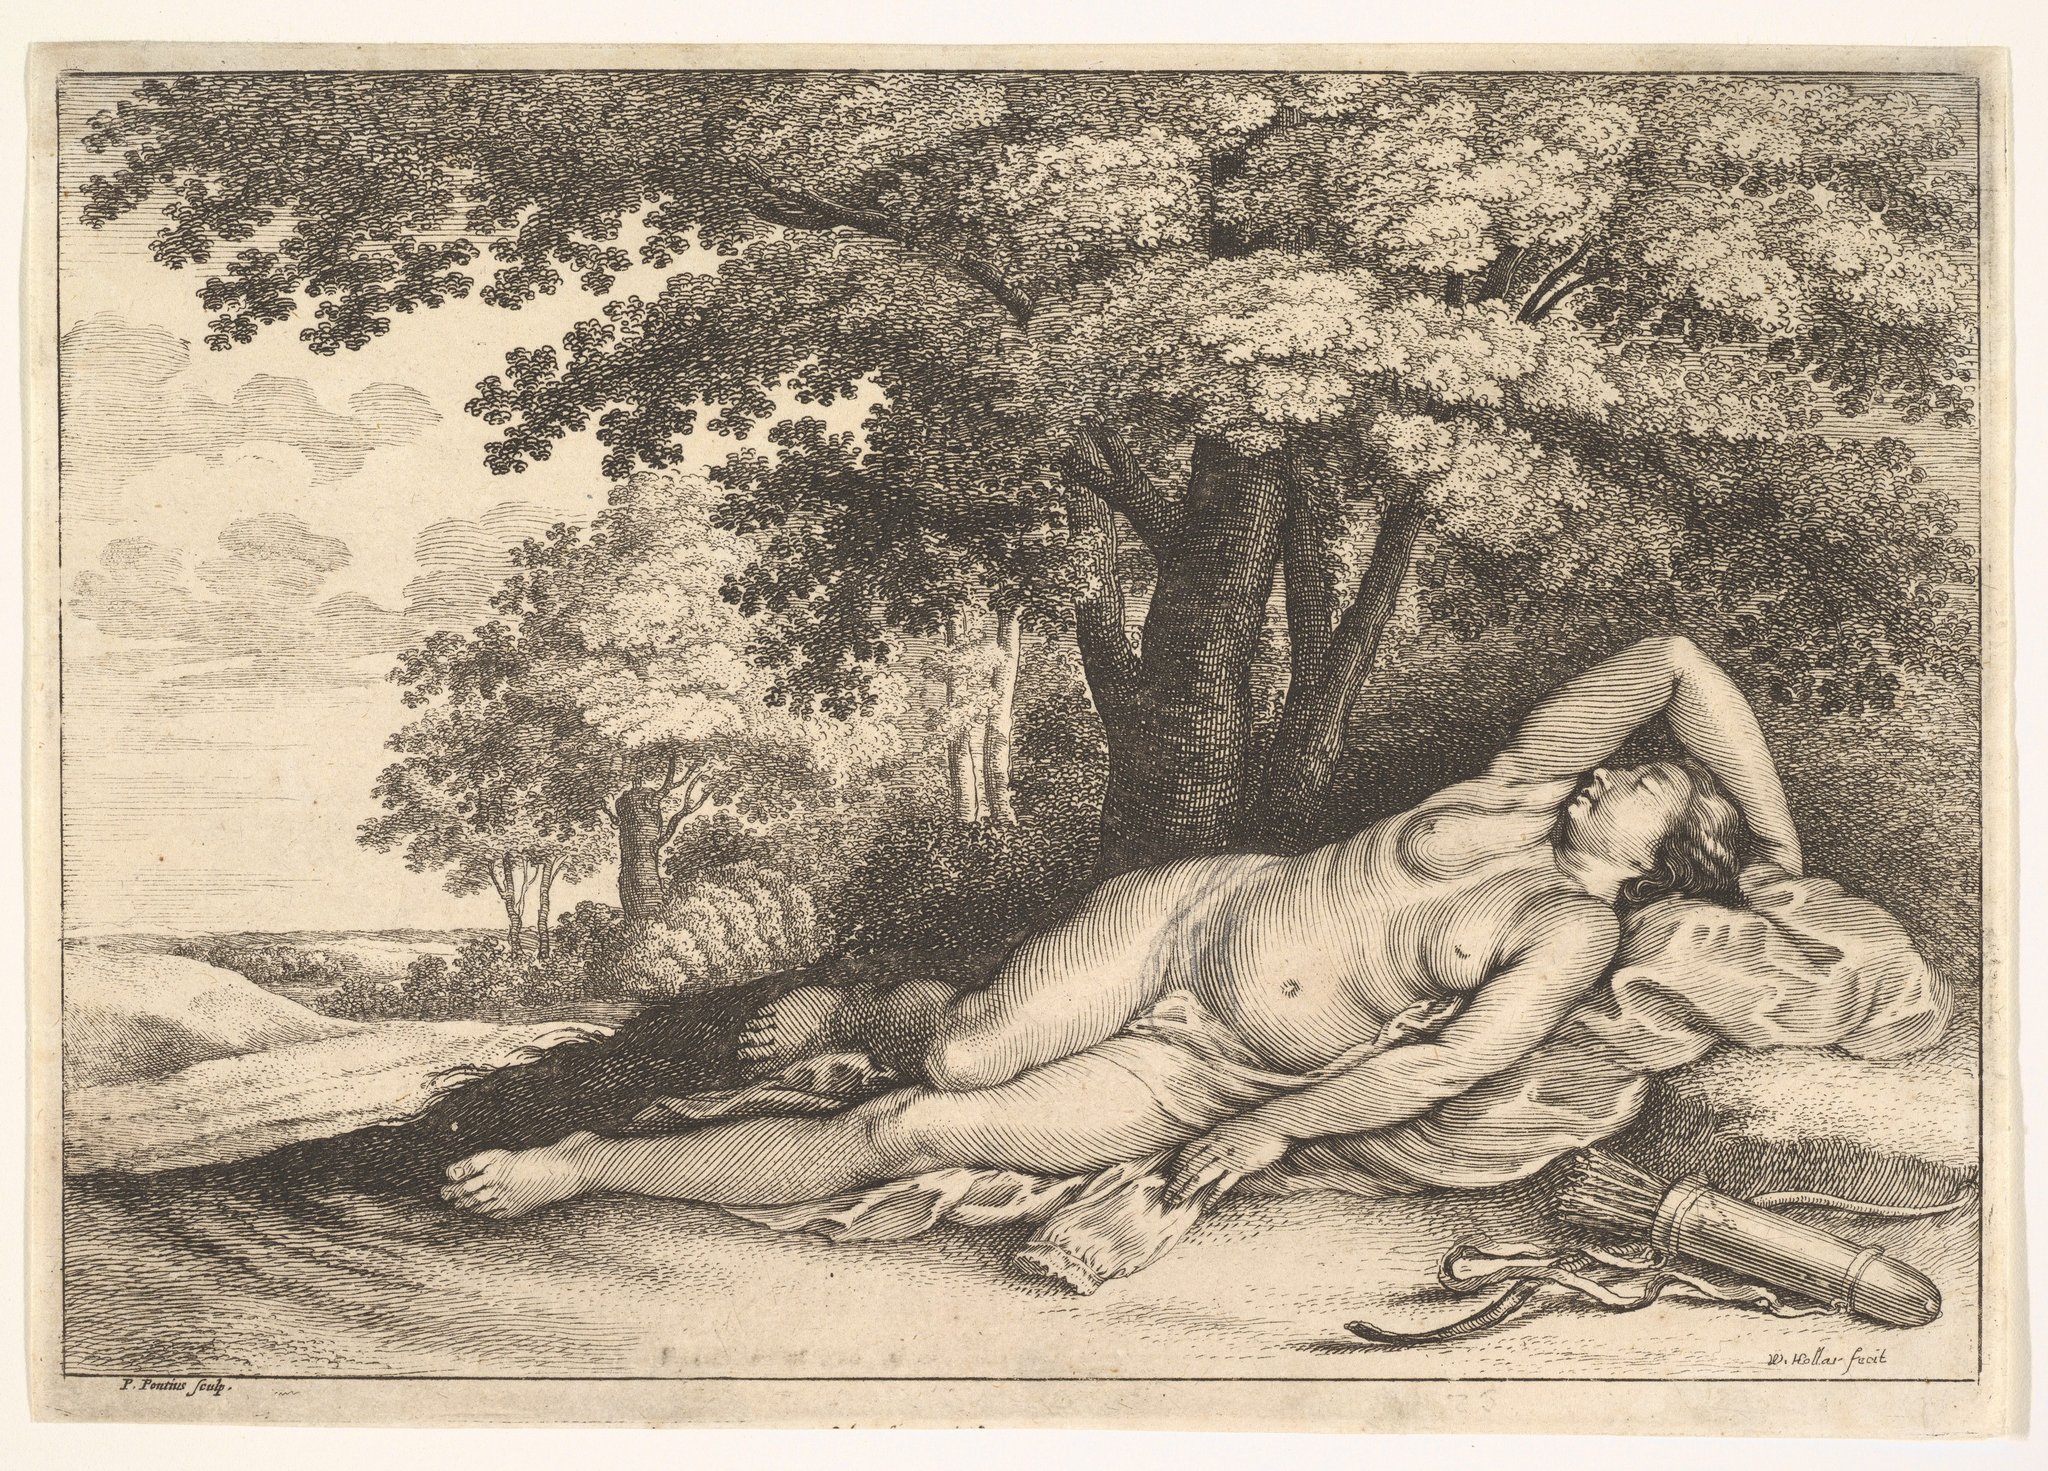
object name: print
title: Sleeping Huntress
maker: wenceslaus hollar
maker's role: artist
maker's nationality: bohemian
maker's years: 1607-1677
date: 1644-1652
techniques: engraving, etching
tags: bow and arrow,sleeping,female nudes,trees